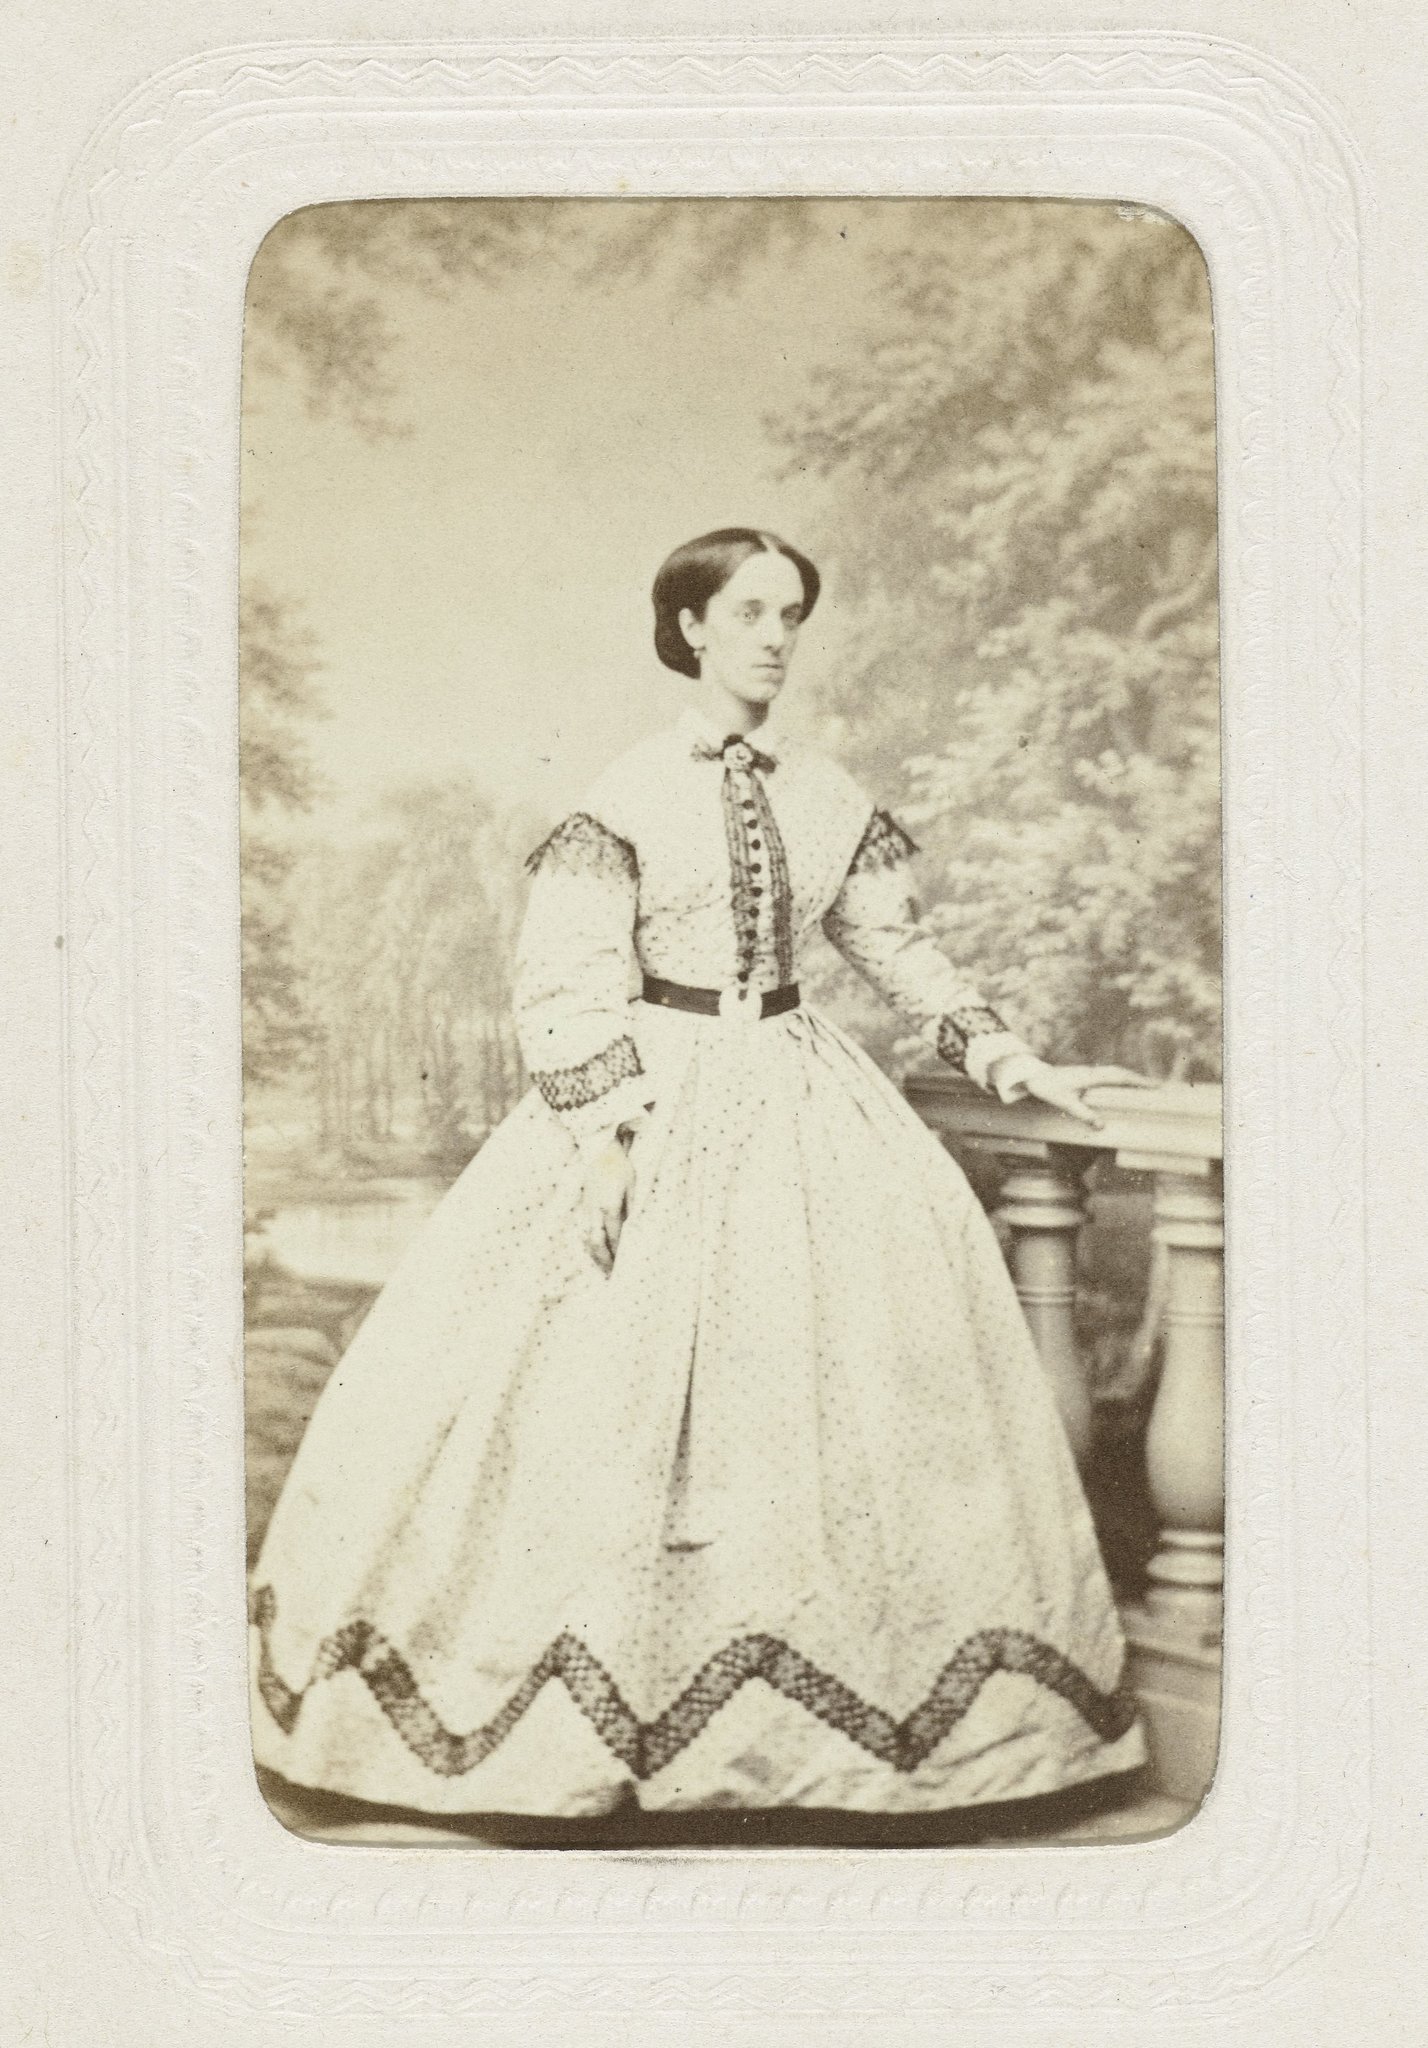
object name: carte de visite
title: Studioportret van een jonge vrouw in een lange jurk met stippen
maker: a herbst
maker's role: fotograaf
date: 1863-1870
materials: cardboard, paper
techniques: albumen print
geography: germany